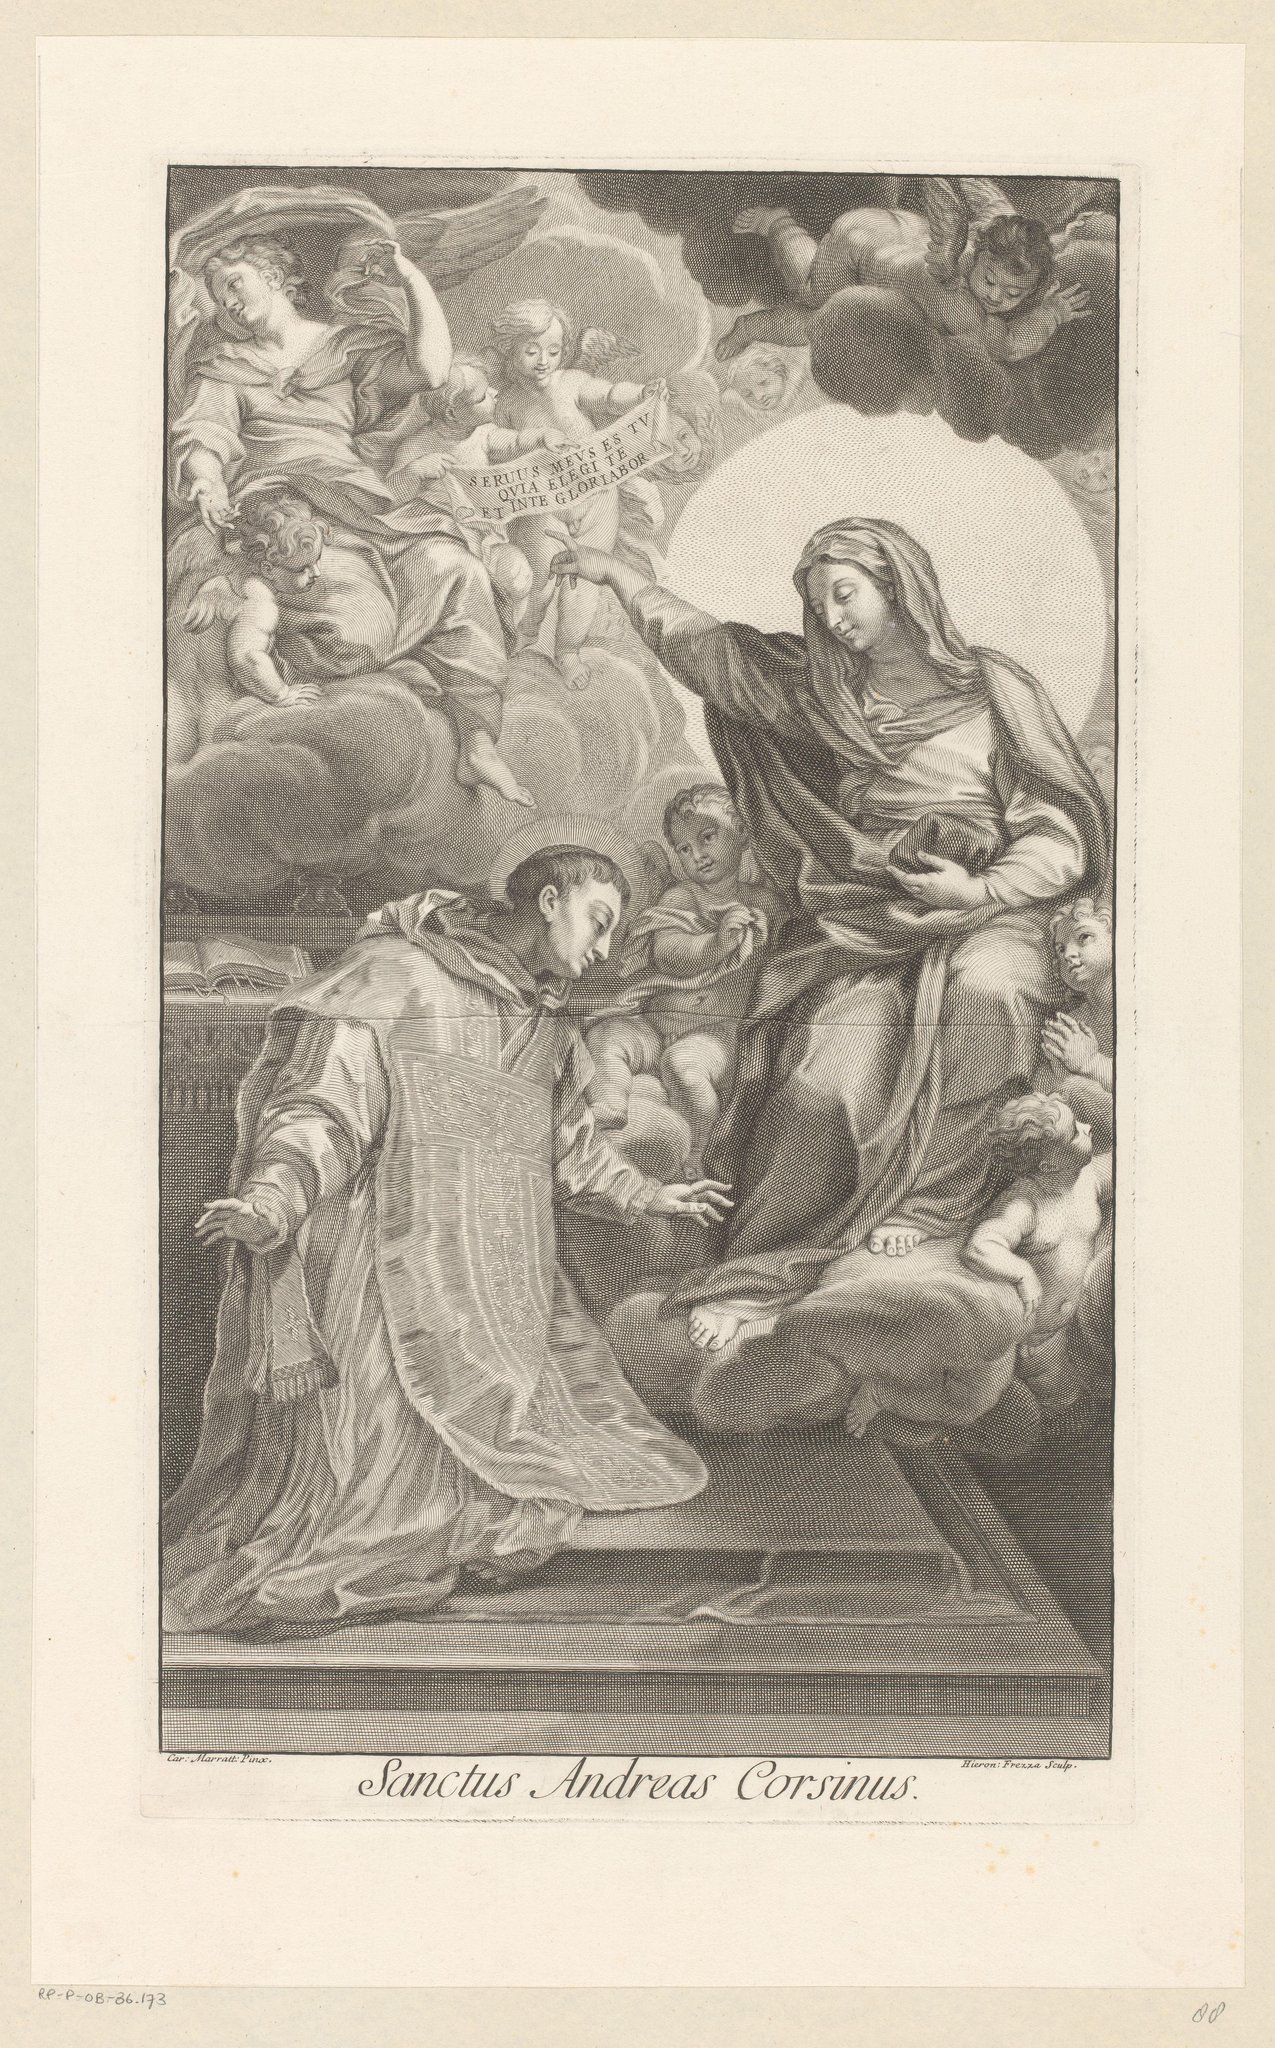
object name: print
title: De heilige Andreas Corsini knielend voor Maria met Kind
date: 1686-1748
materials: paper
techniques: engraving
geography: italy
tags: madonna: i.e. mary with the christ-child, andrew corsini, carmelite friar and bishop of fiesole; possible attributes: aspergillum, lamb, sword, wolf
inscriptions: collector's mark: Lugt 240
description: De heilige Andreas Corsini knielend voor Maria met Kind. Rondom Maria en het Christuskind zweven putti. Maria wijst naar een blad met de tekst: S eruus meus es tu / quia elegi te / et inte gloriabor.